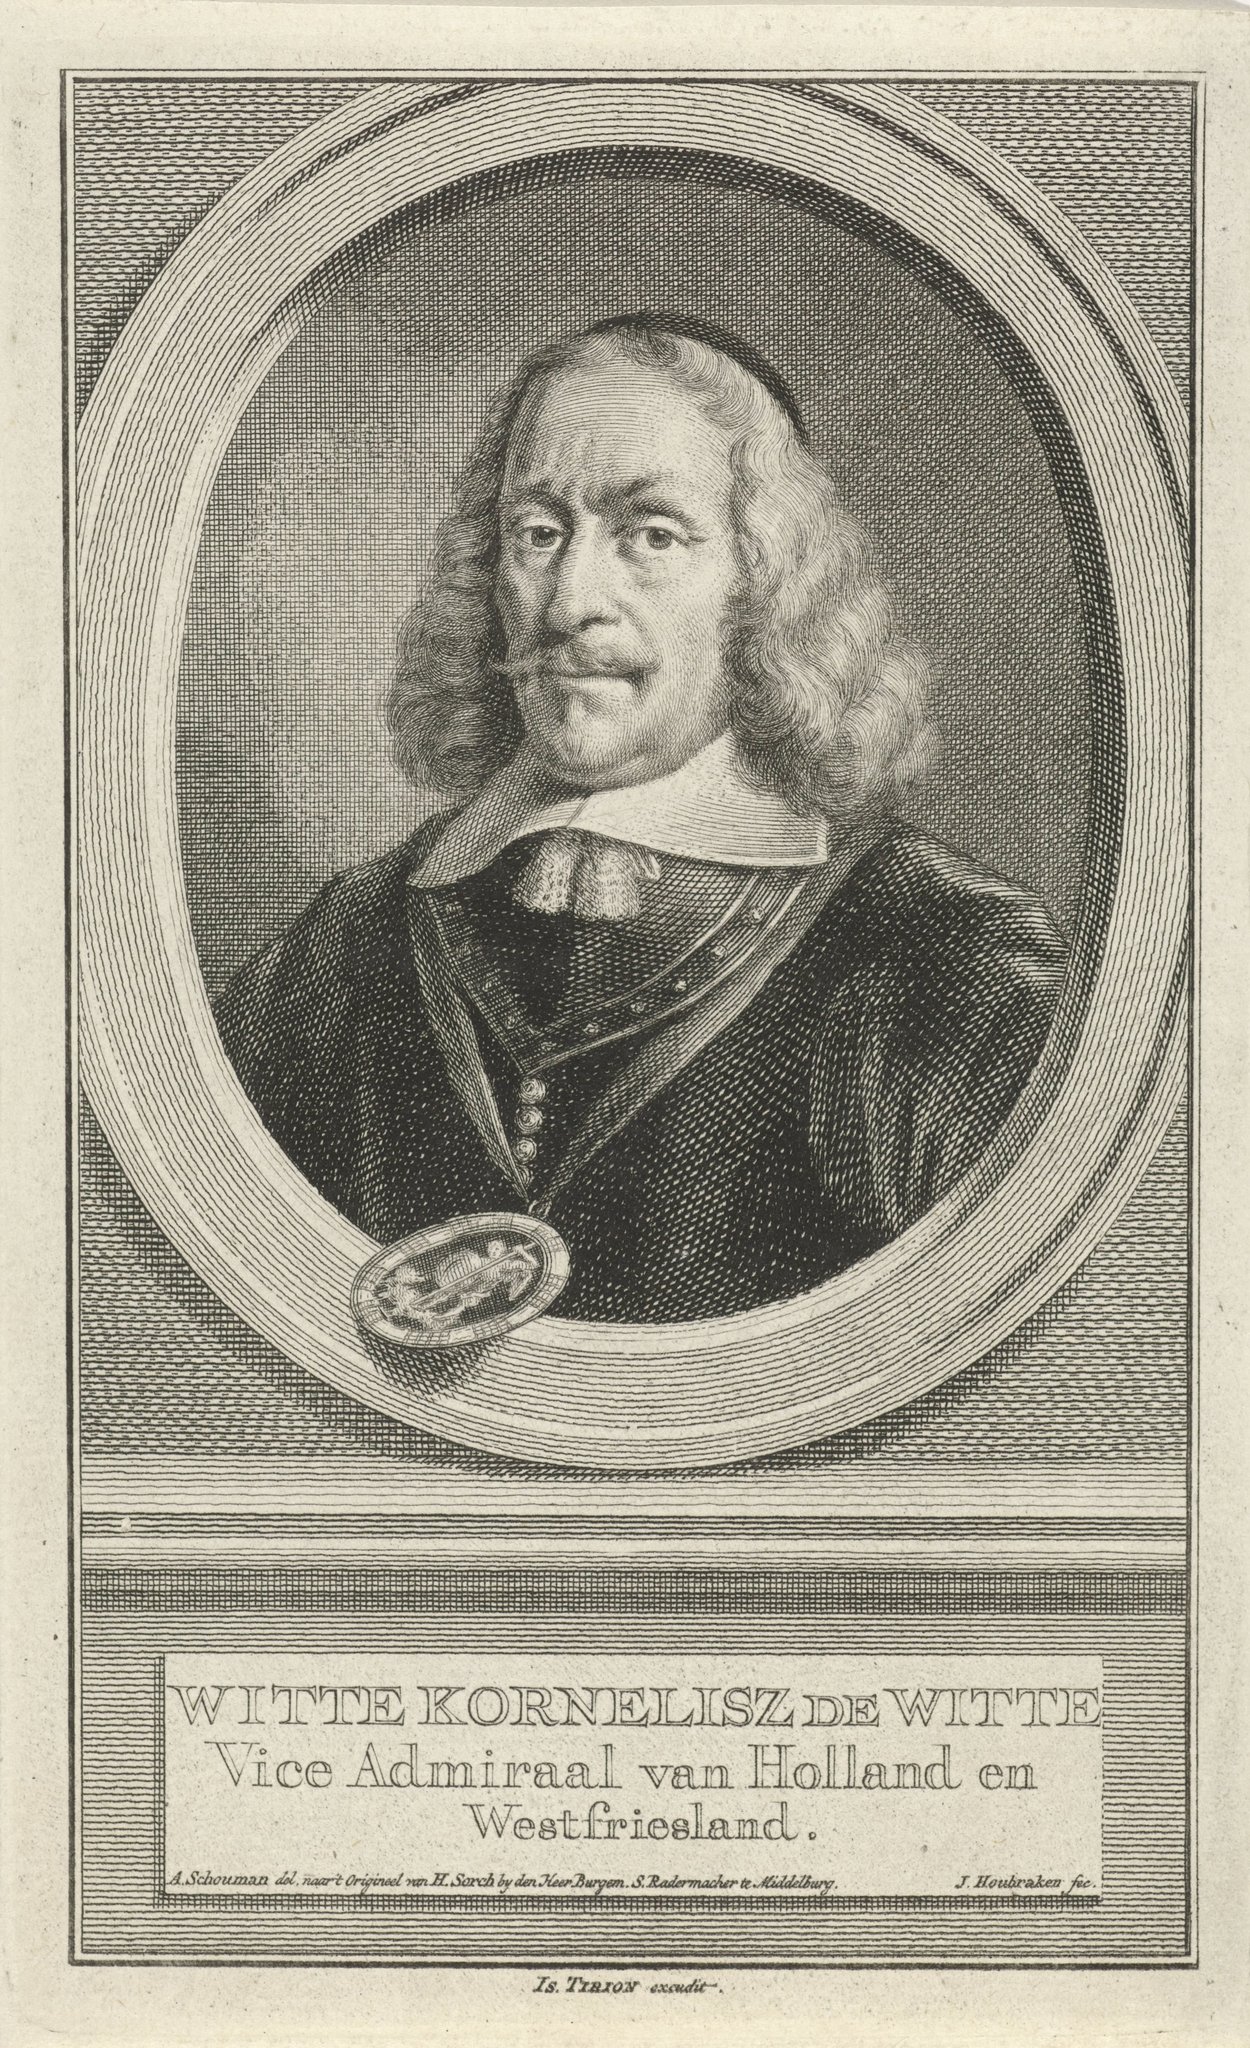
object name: print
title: Portret van Witte Cornelisz. de With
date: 1749-1759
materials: paper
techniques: engraving, etching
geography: amsterdam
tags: hoogendijk, zeeofficier, witte cornelisz. de with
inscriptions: collector's mark: Lugt 2228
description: Prent ook gebruikt in: Jan Wagenaar, Vaderlandsche historie, vervattende de geschiedenissen der nu Vereenigde Nederlanden, inzonderheid die van Holland (...), 21 delen. Amsterdam, Isaak Tirion, 1749-59.